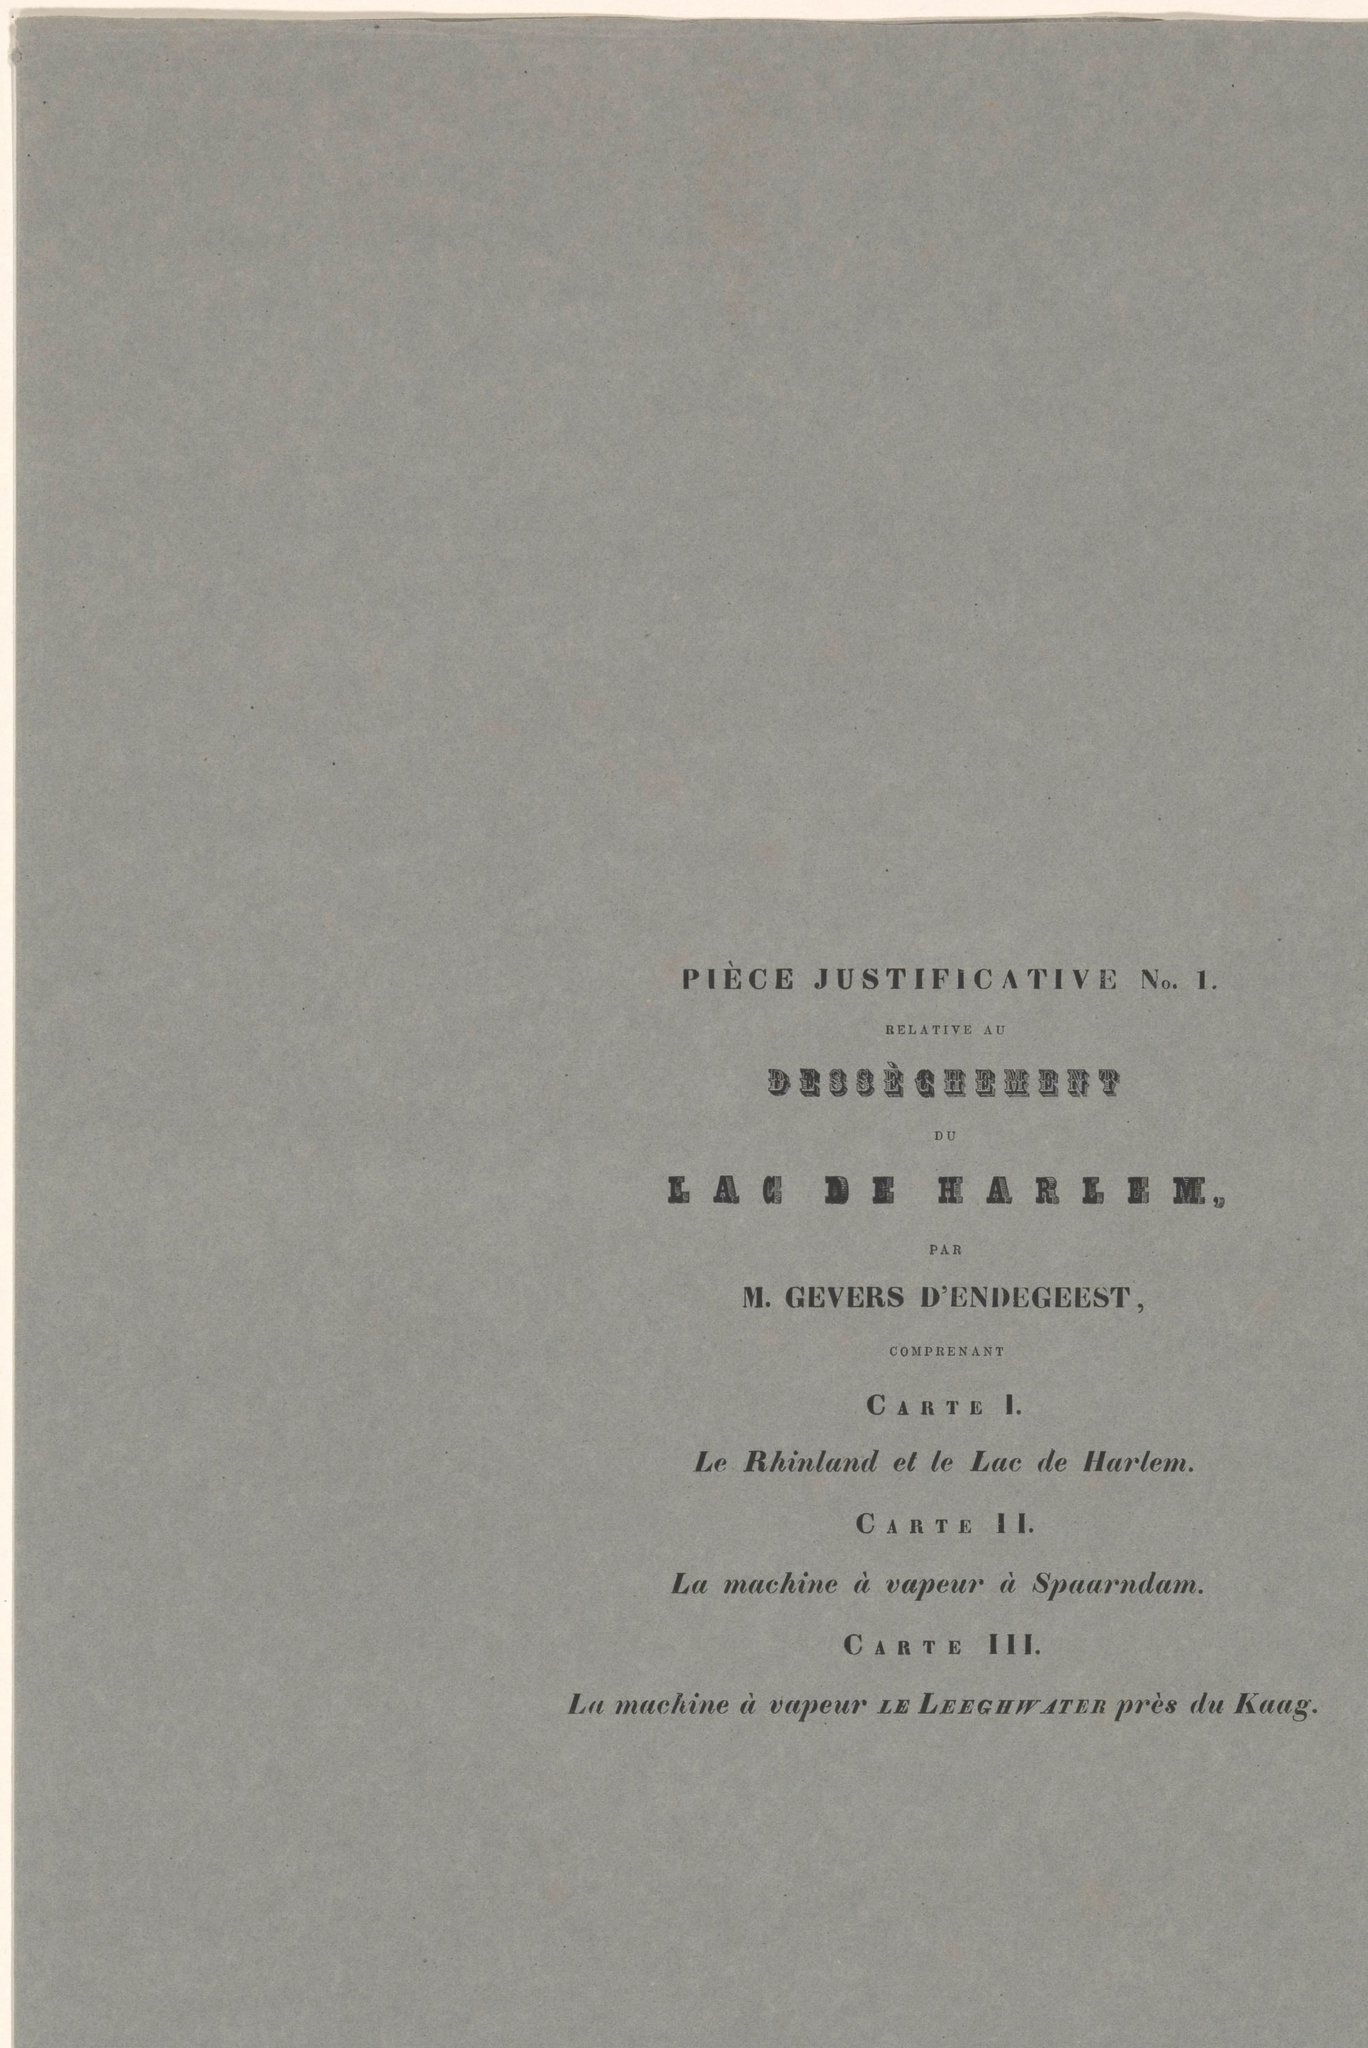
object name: text sheet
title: Suite van tien kaarten en platen van de droogmaking van de Haarlemmermeer 1843-1860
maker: Anonymous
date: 1843-1861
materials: paper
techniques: letterpress printing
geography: netherlands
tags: haarlemmermeer, haarlemmermeerpolder, drooglegging van de haarlemmermeer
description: Uitgegeven als illustratie in: Daniel Theodoor Gevers van Endegeest, Over de droogmaking van het Haarlemmermeer. 3 dln., Leiden : S. en J. Luchtmans. Uitg. later: 's Gravenhage : Gebroeders van Cleef, en: Amsterdam : Fred. Muller. 1843-1861.